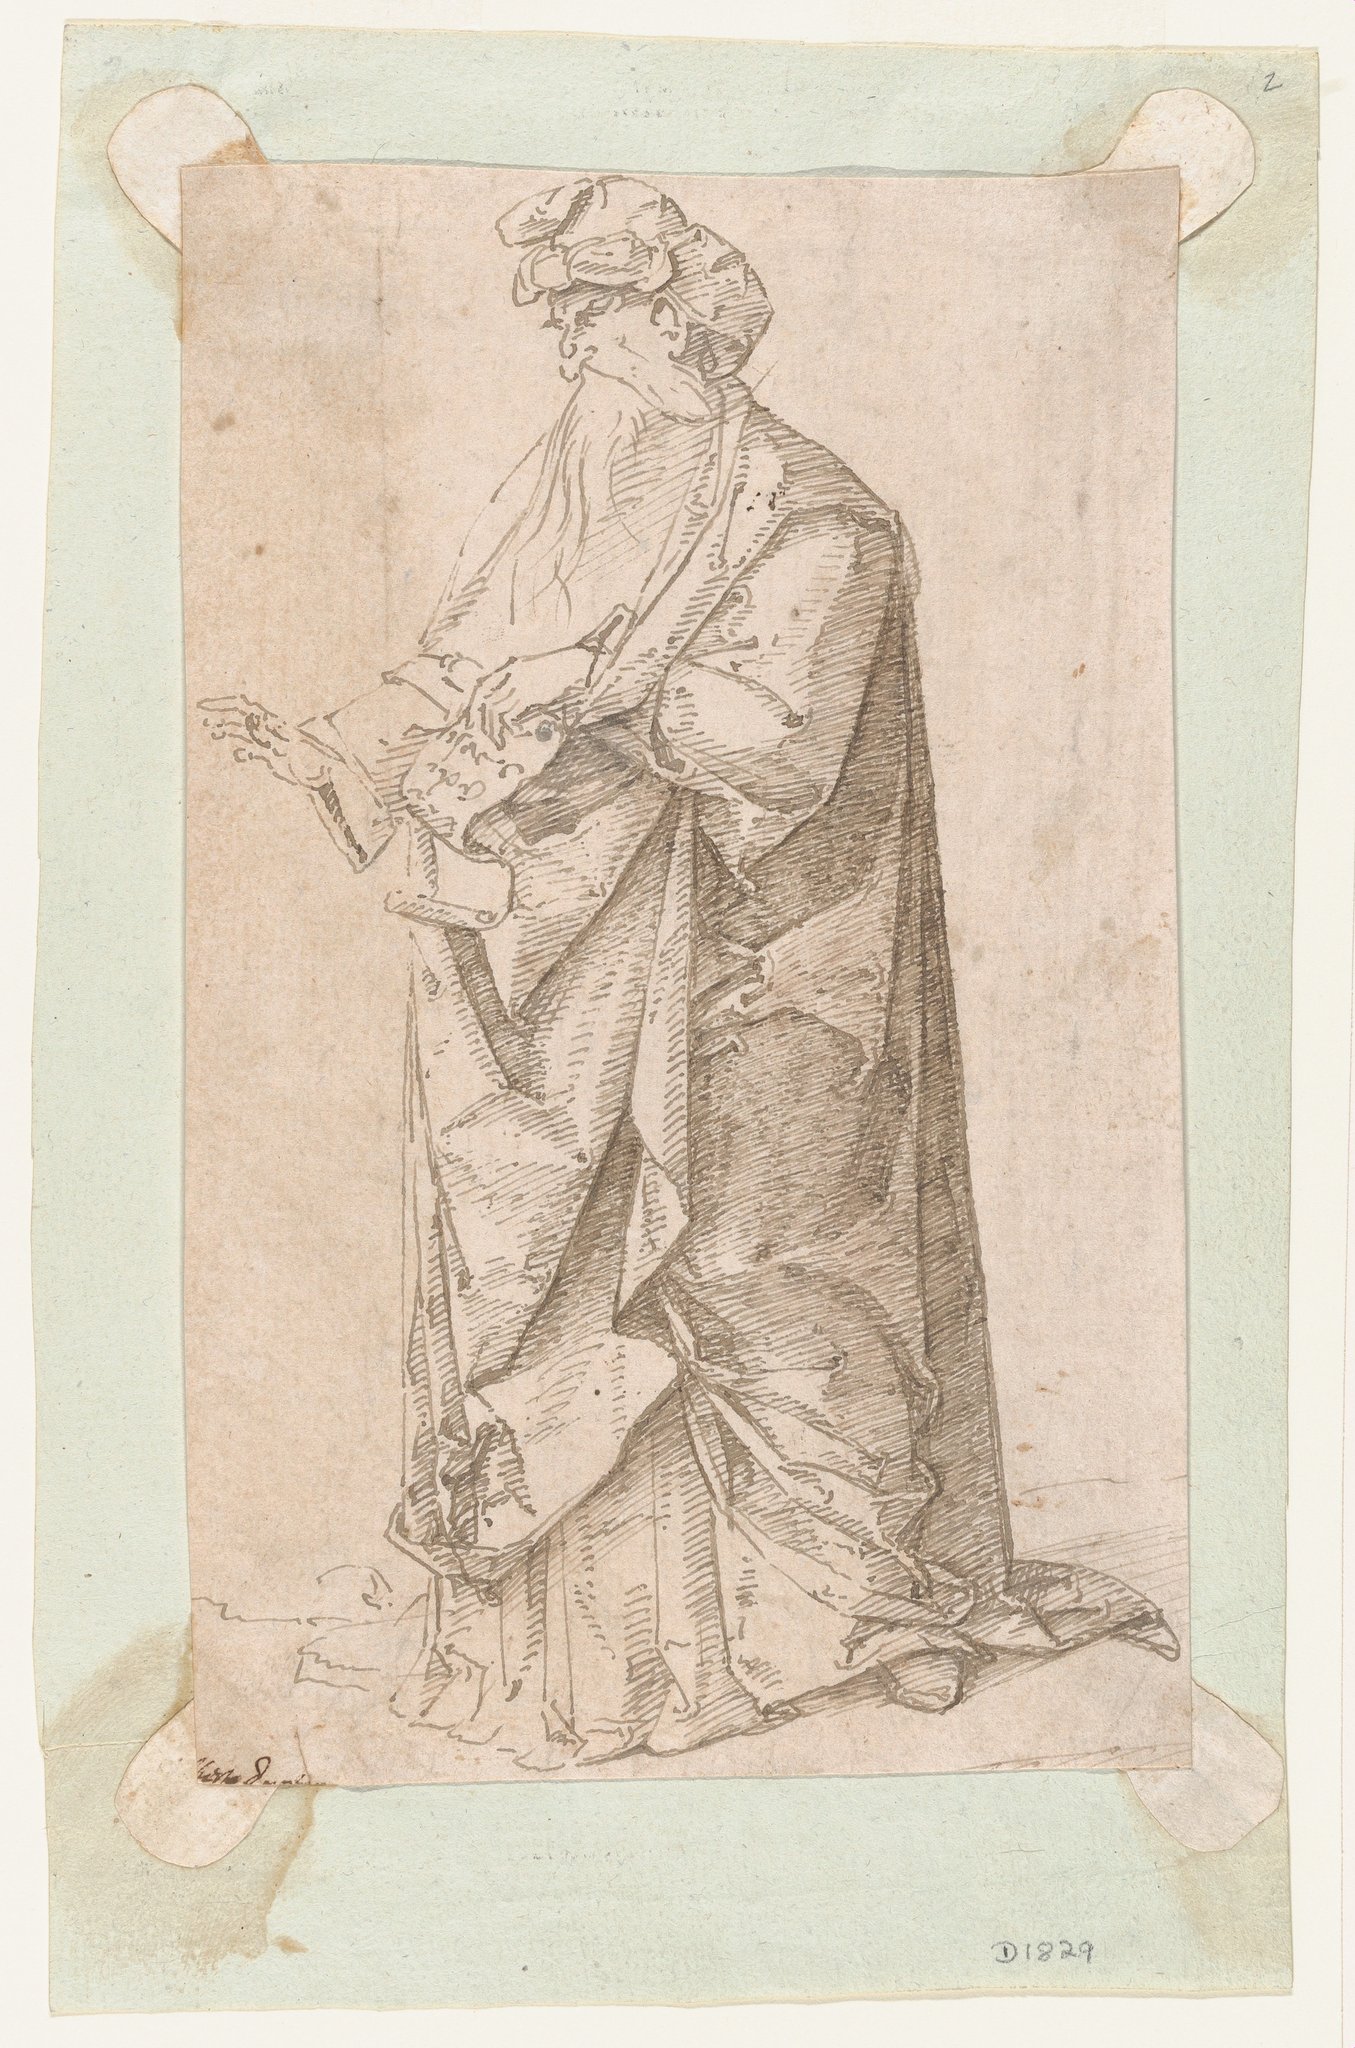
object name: drawing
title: Standing Male Figure with a Scroll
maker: circle of andrea mantegna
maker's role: artist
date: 1500-1506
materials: ink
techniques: pen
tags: men